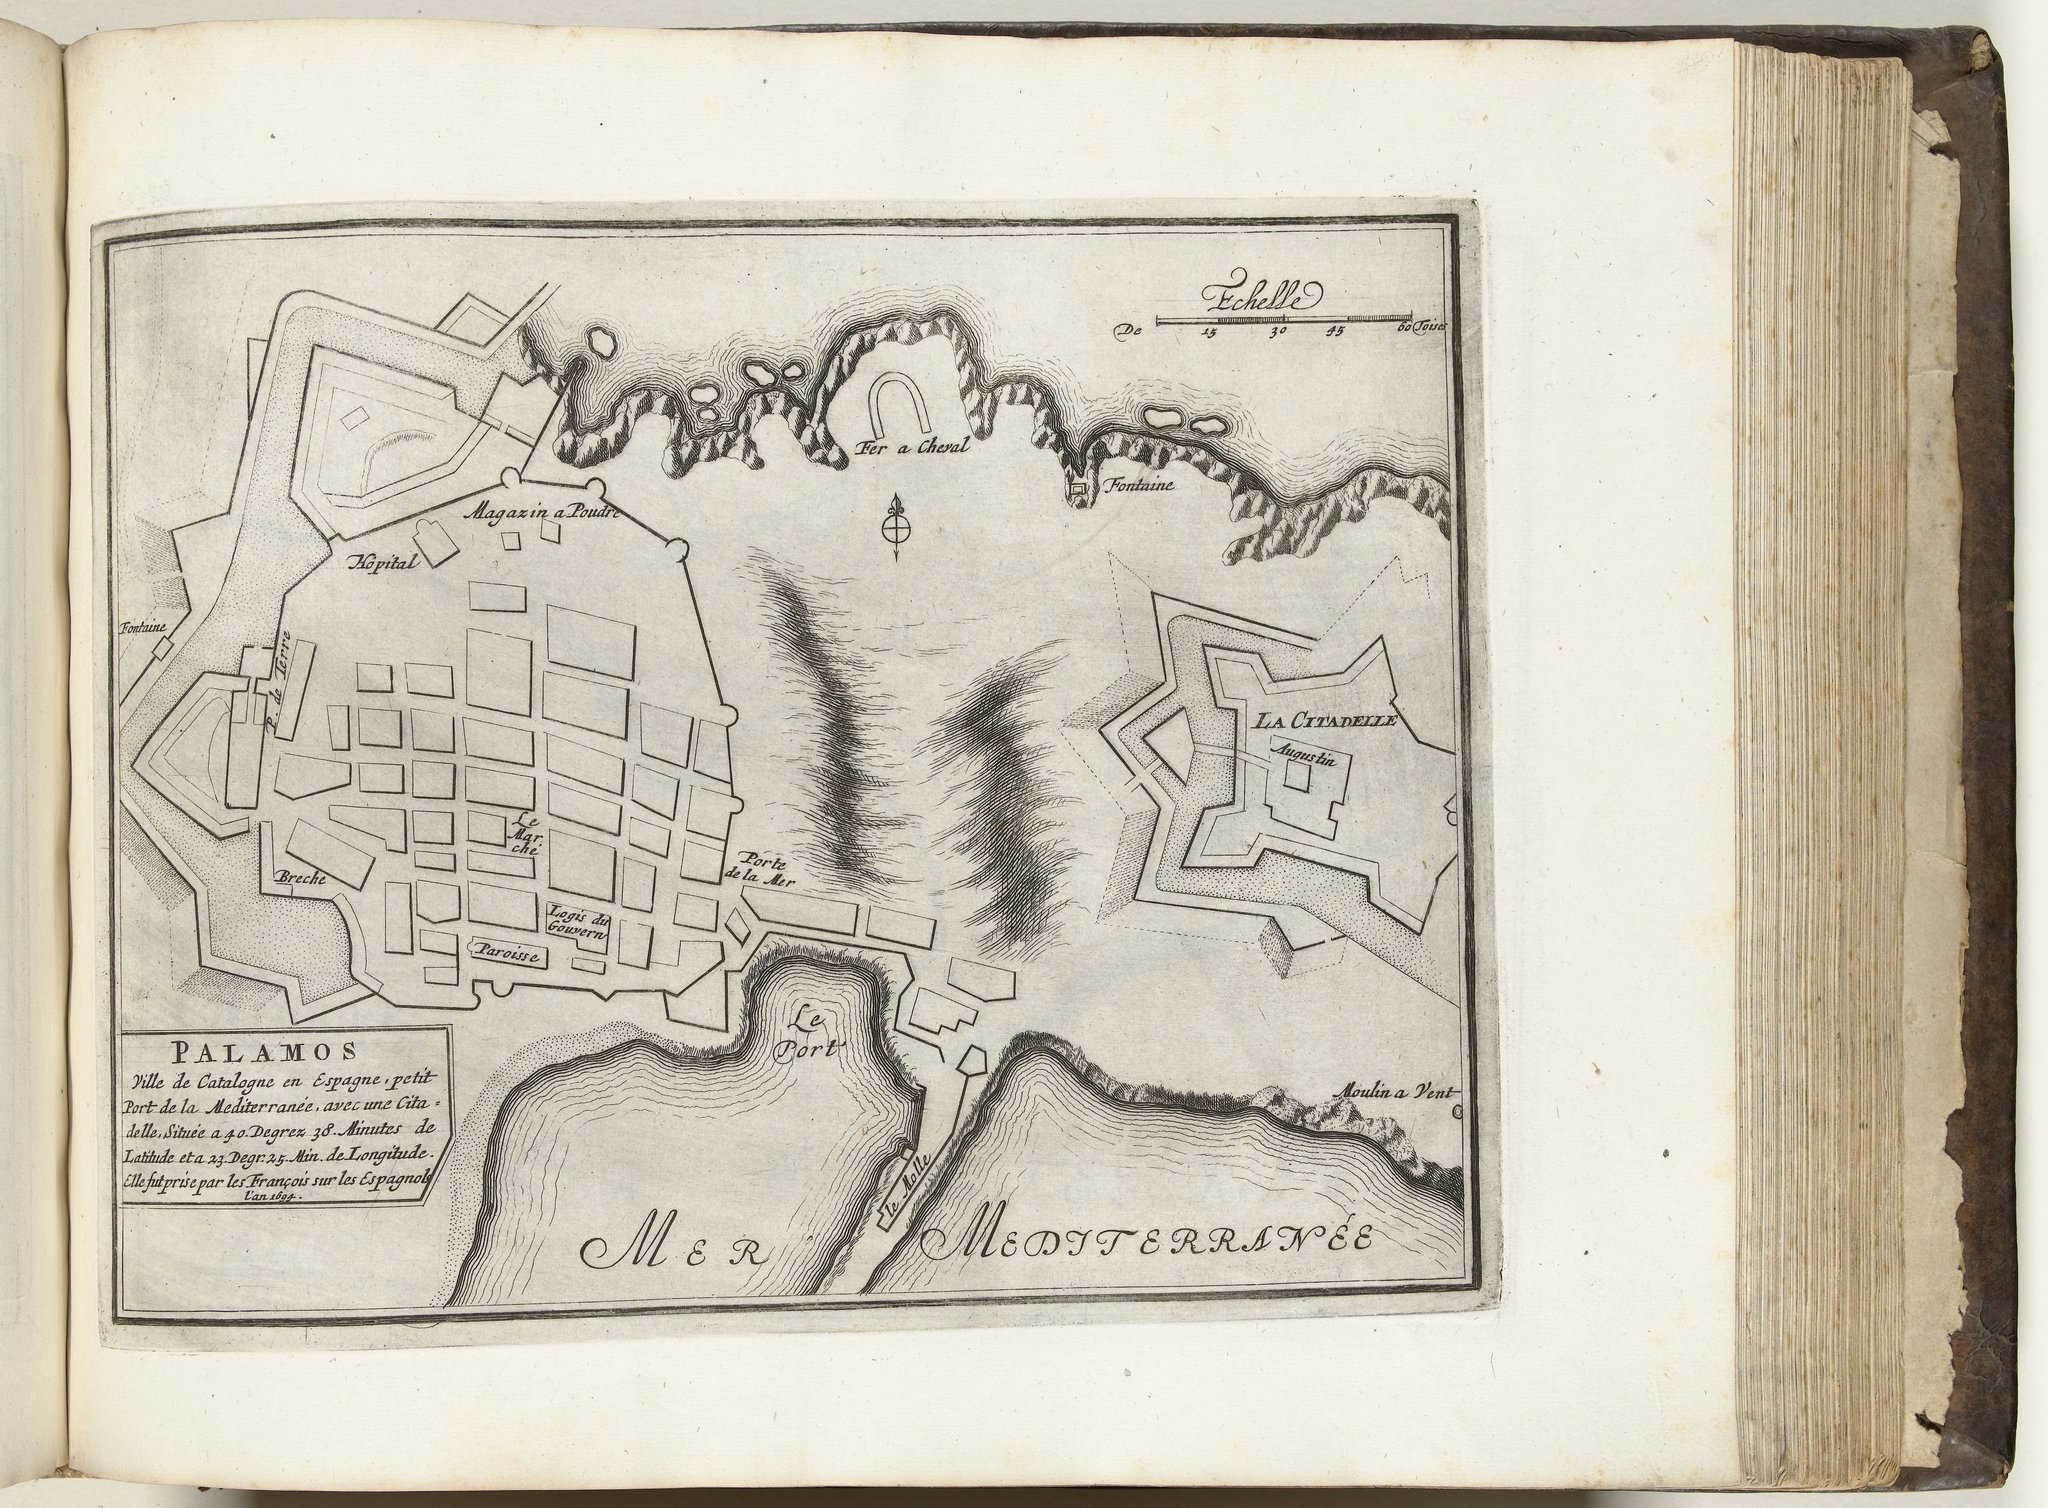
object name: print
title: Plattegrond van Palamos, 1694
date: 1694-1696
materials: paper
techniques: engraving, etching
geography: paris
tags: fortress, maps of cities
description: Plattegrond van de versterkingen om de Spaanse stad Palamos, veroverd door de Fransen in 1694. Onderdeel van het zevende deel (1696) van het prentwerk waarin gebundeld zijn de acht delen van Les forces de l'Europe uitgegeven tussen 1693-1697. Het prentwerk bestaat uit 175 platen met plannen (afkomstig van Sébastien Le Prestre, Seigneur de Vauban) van vermaarde sterke steden en vestingen in de Negenjarige Oorlog. Titel en opschriften in het Frans.